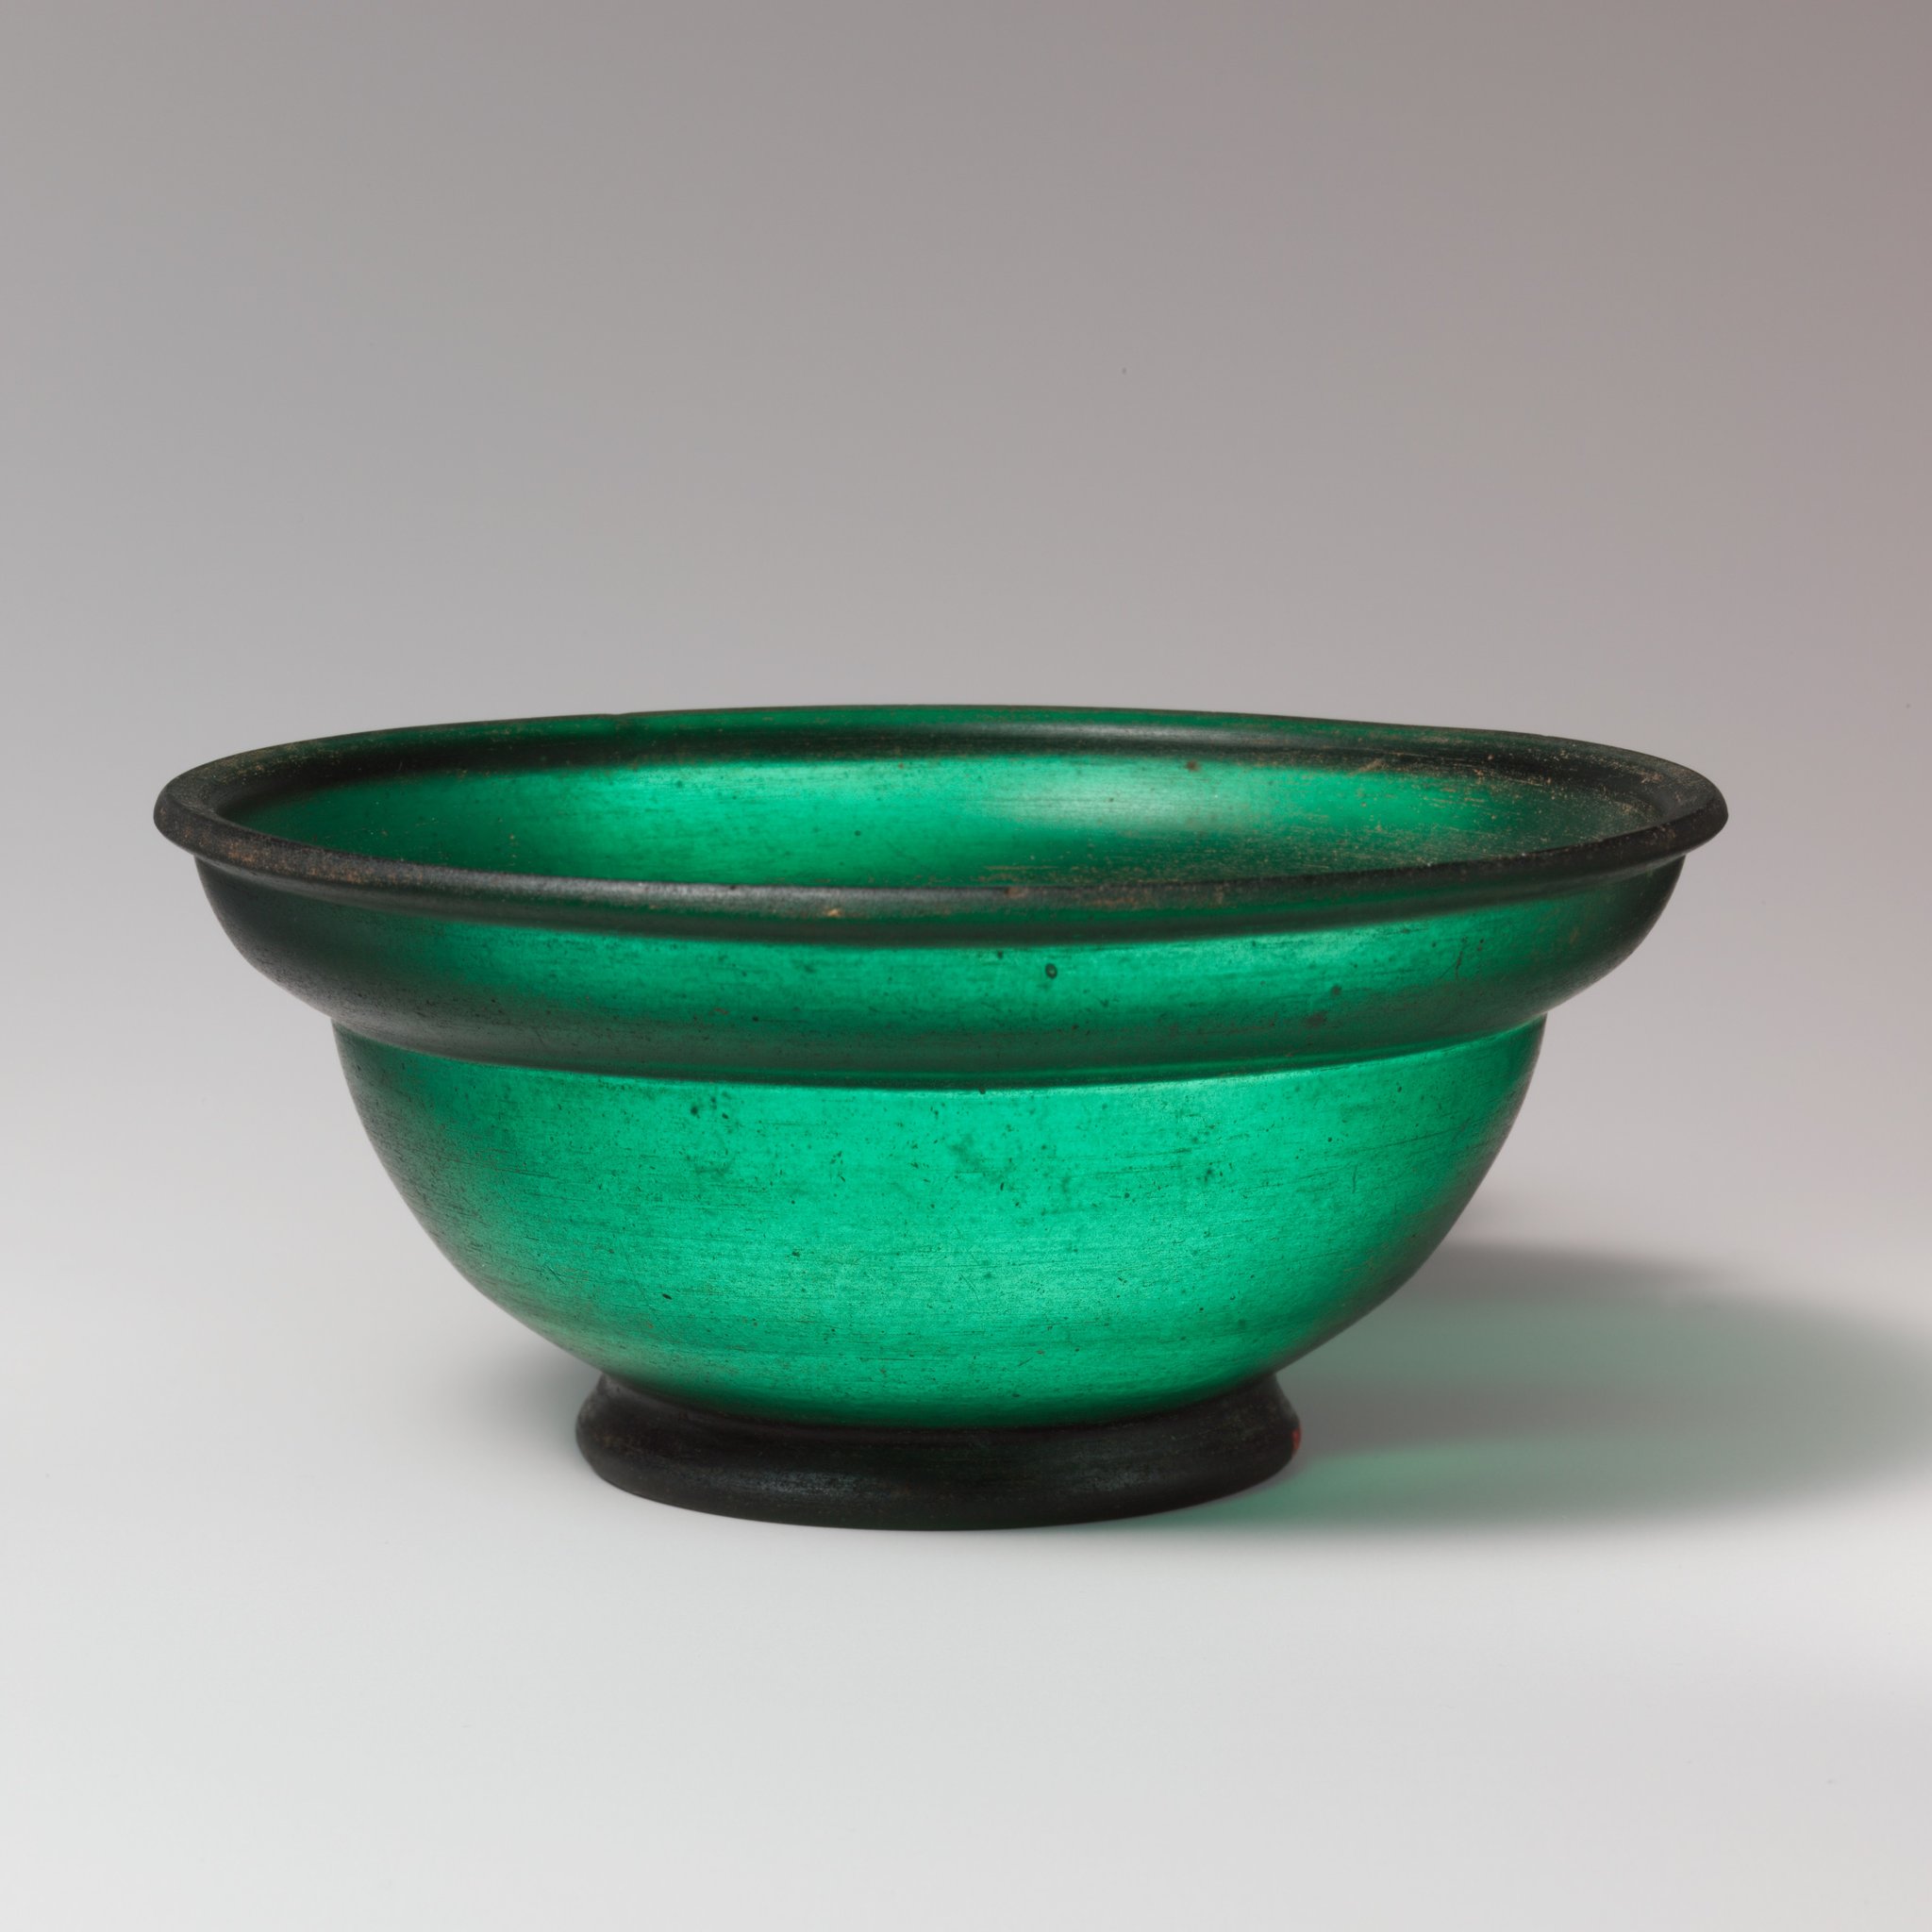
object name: bowl, patella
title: Glass bowl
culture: roman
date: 1-50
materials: glass